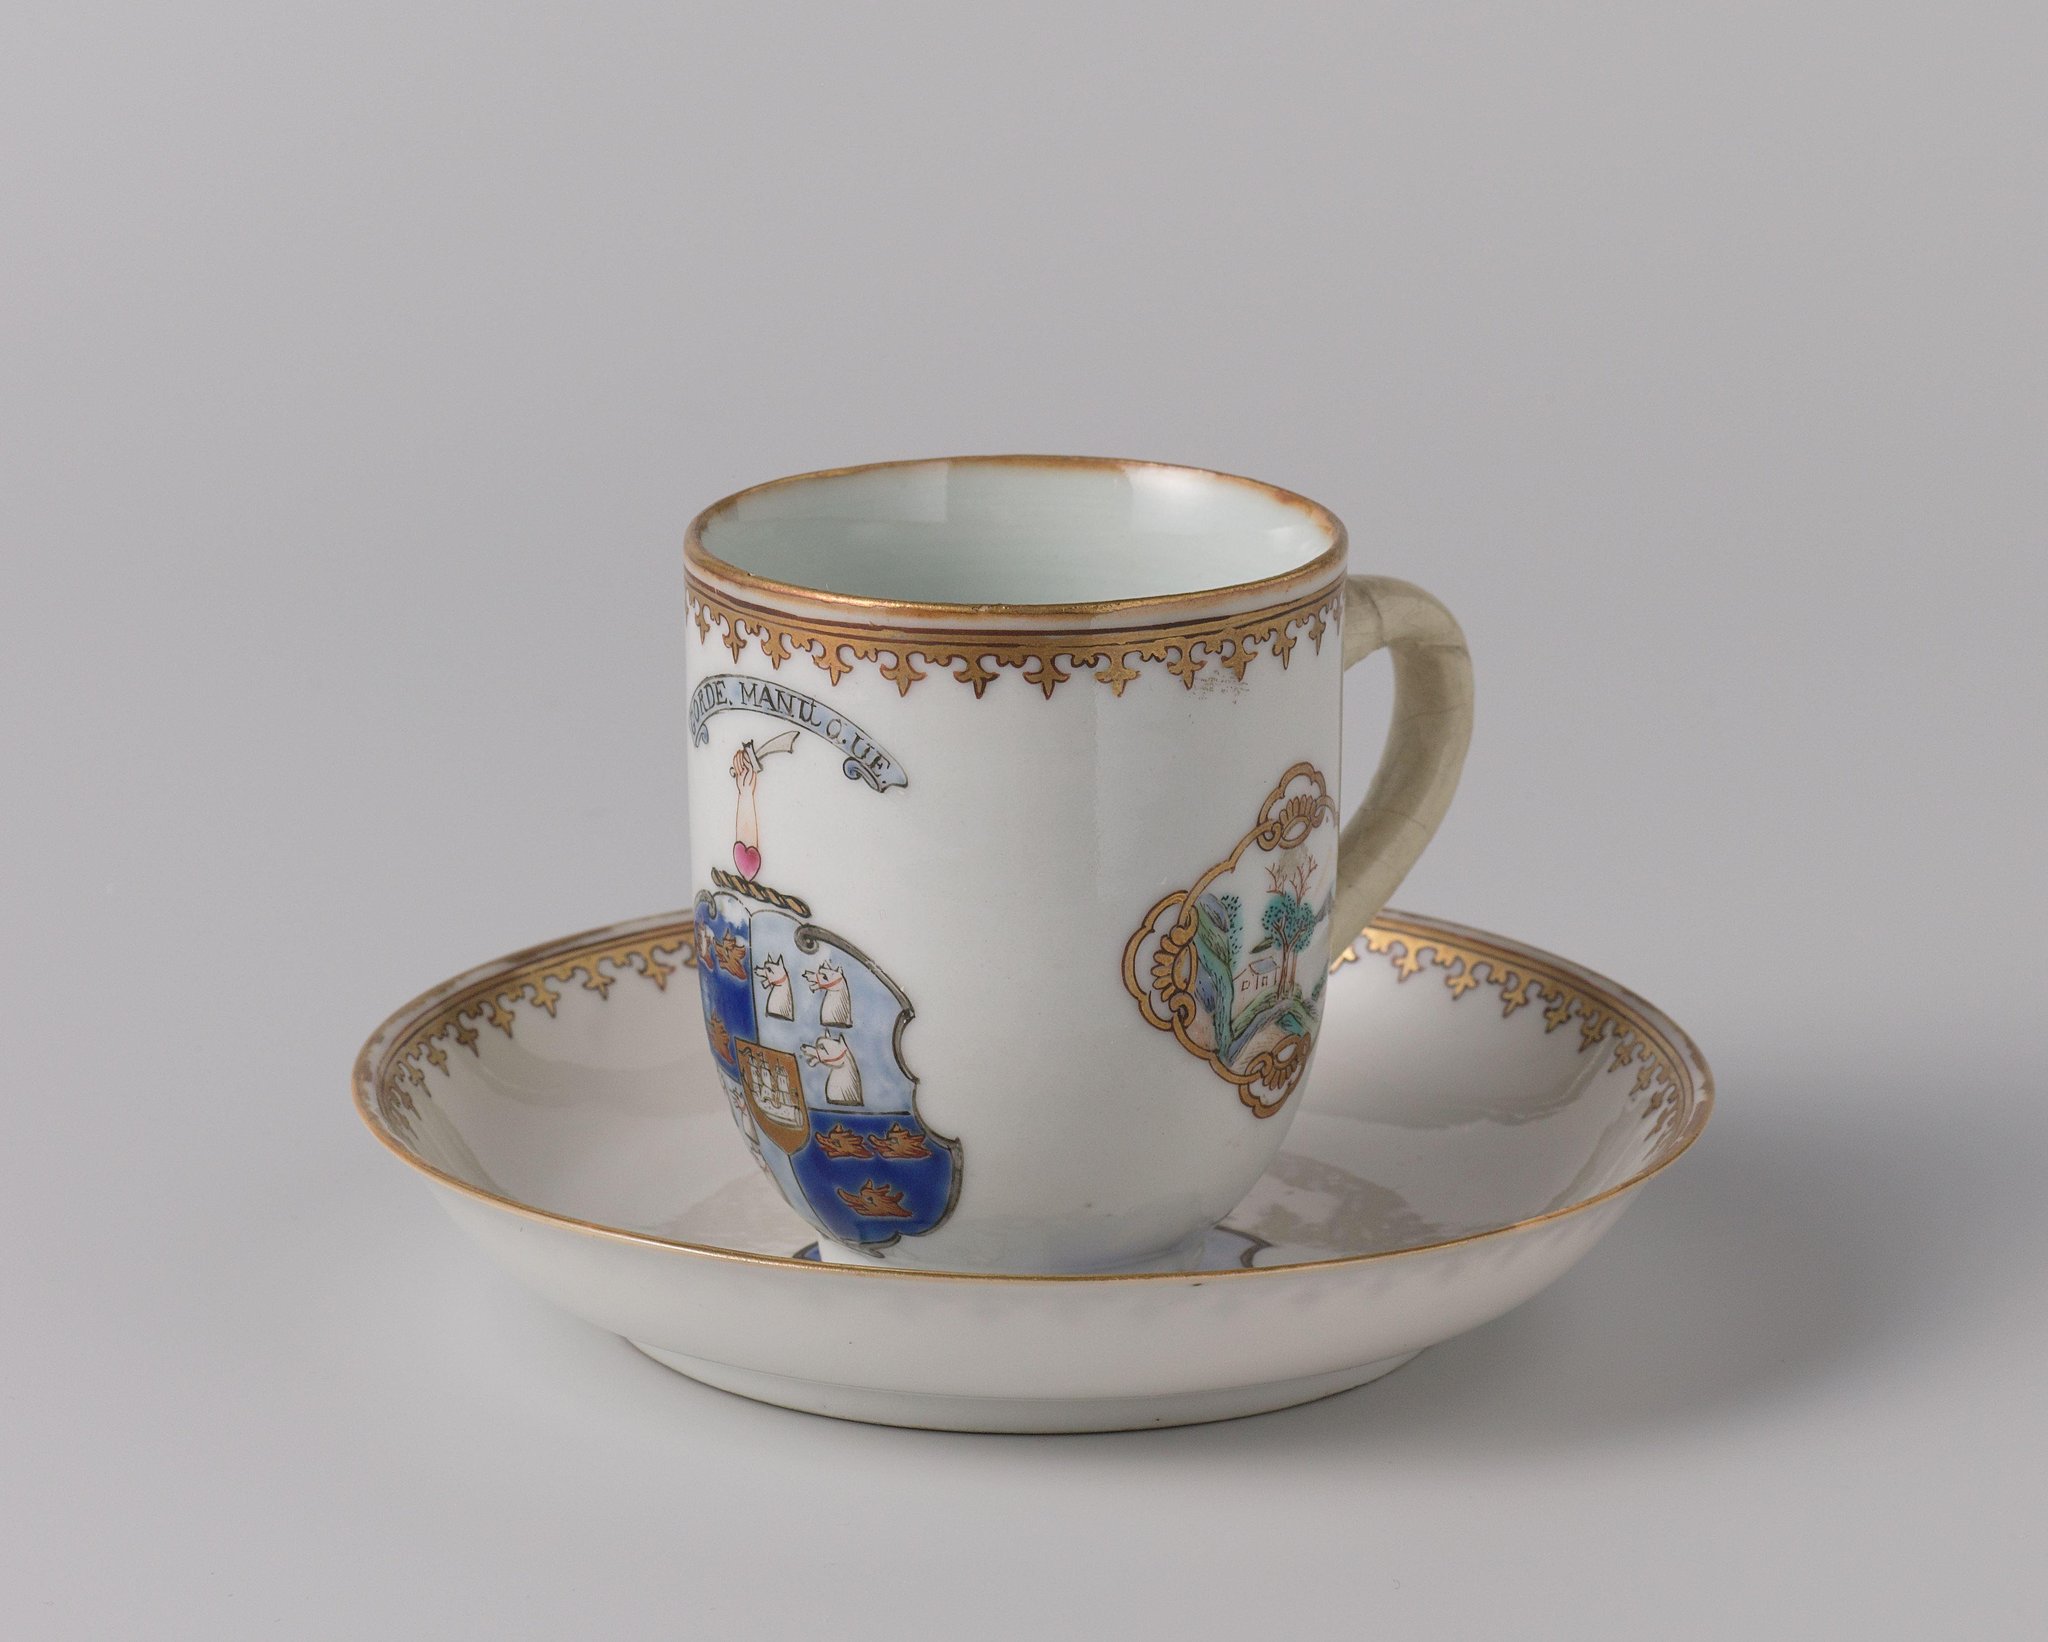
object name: kop en schotel, kop en schotel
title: Saucer with the arms of the families Gordon and Forbes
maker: Anonymous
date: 1750-1774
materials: glaze, gold, paint, porcelain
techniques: firing, gilding, turning, vitrification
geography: china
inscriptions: inscription: ‘CORDE MANUQUE’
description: Schotel van porselein, beschilderd op het glazuur in blauw, rood, roze, groen, geel, zwart en goud. Op het plat van de schotel het wapen van de families Gordon en Forbes. Het wapen is verdeeld in vier vakken met Gordon in 1. en 4. met drie zwijnenkoppen tegen een blauwe achtergrond; 2. en 3. Forbes met drie koppen op een lichtblauwe achtergrond. Het helmteken is een arm met een zwaard en het opschrift 'CORDE MANUQUE'. Op de binnenrand een spearhead-border. Wapenporselein met emailkleuren.